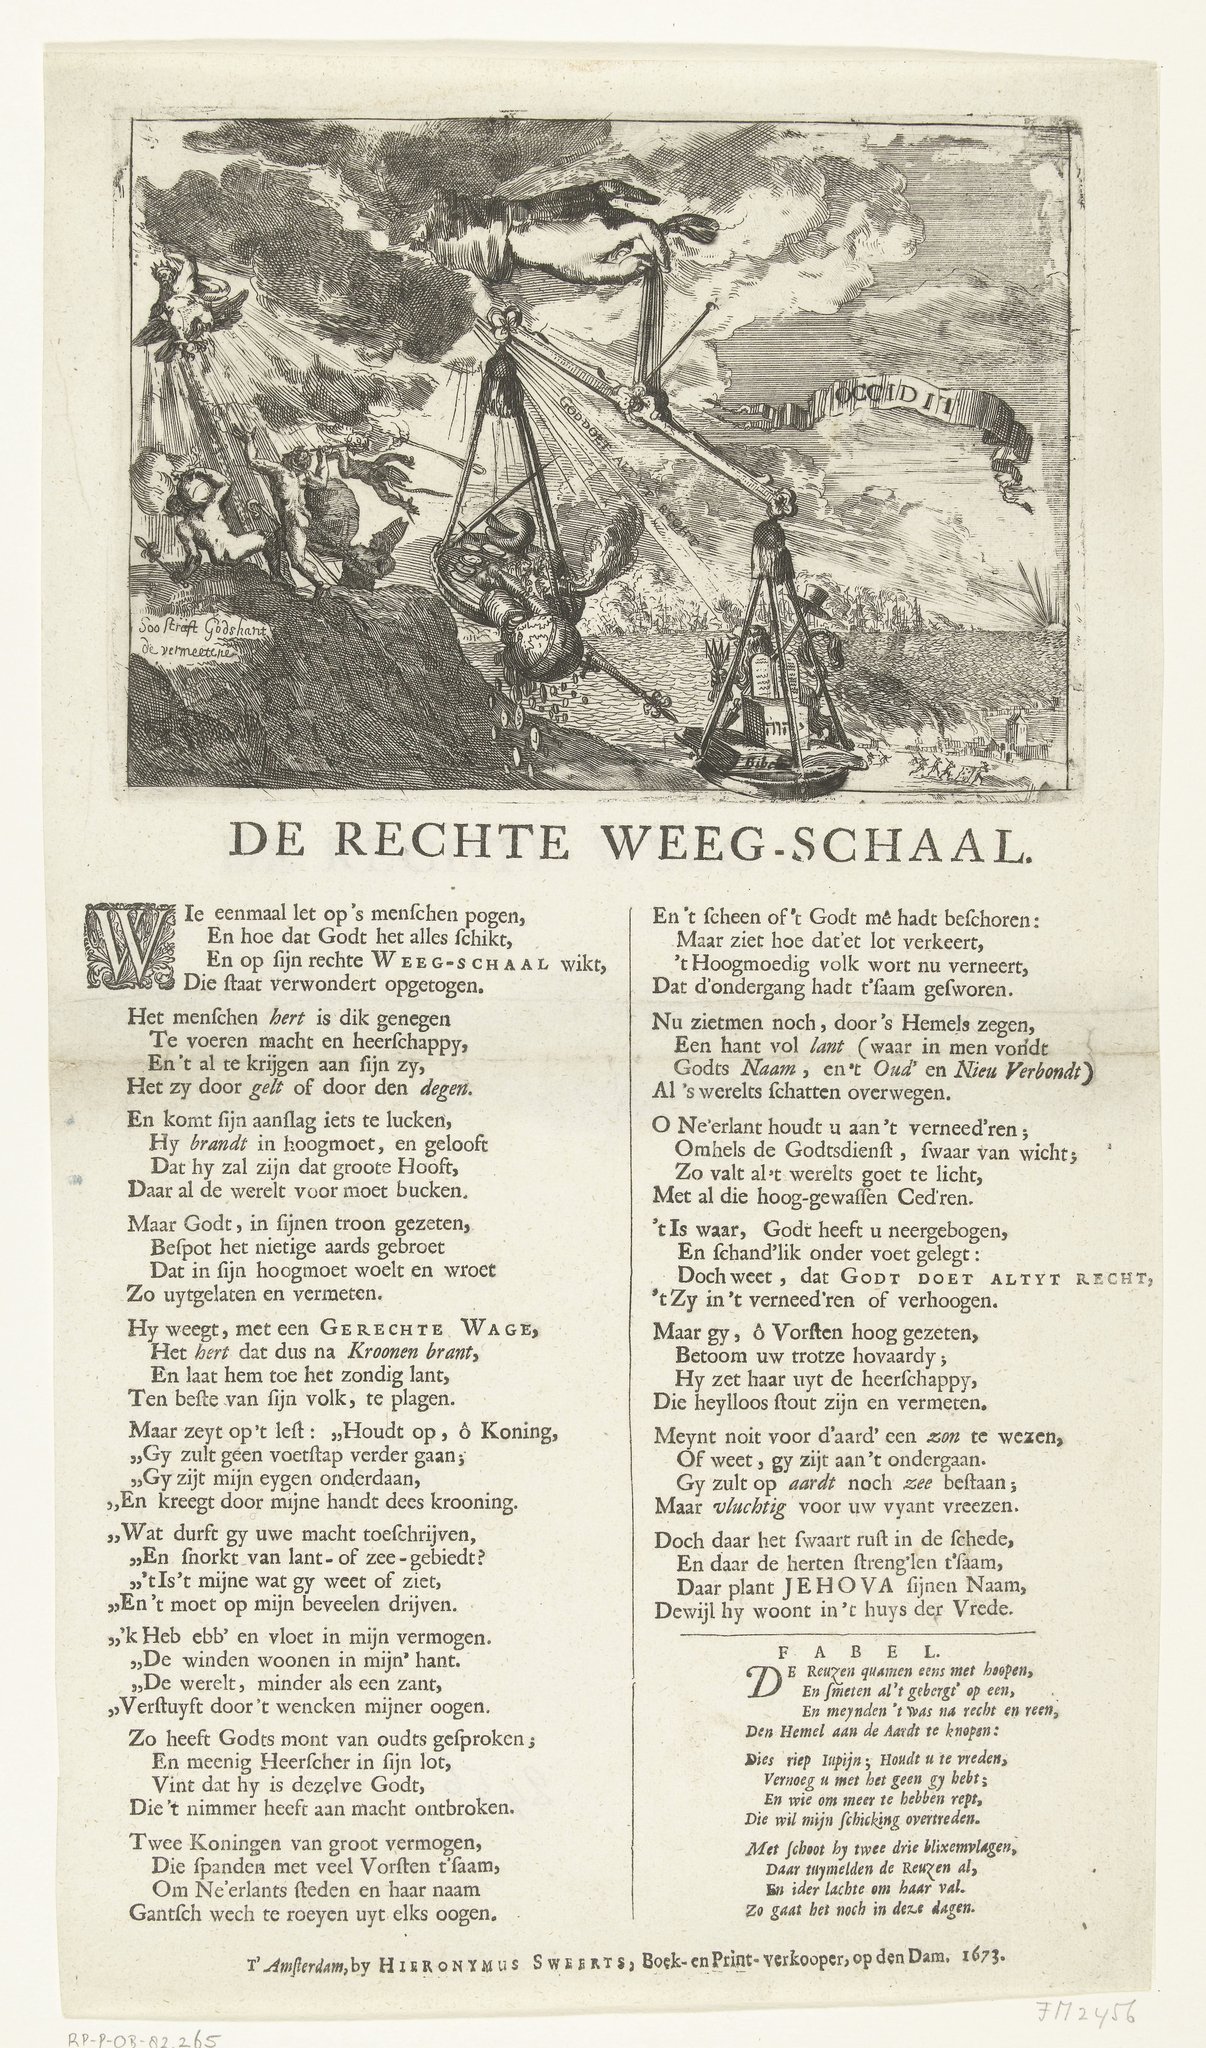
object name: print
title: Allegorie op de politieke toestand in het jaar 1673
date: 1673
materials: paper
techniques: etching, letterpress printing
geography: amsterdam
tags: scales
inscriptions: date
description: Allegorie op de politieke toestand in het jaar 1673. In een weegschaal in de hand van God worden de vrijheid van de Republiek met bijbel en wetstafelen gewogen tegen het geld en de wapens van de vijanden van de Republiek. Links worden personifacties van Frankrijk en de Duitse bisschoppen gestraft door Jupiter in de wolken. Op de achtergrond een zeeslag en de ondergaande zon. Onder de voorstelling een vers in twee kolommen.